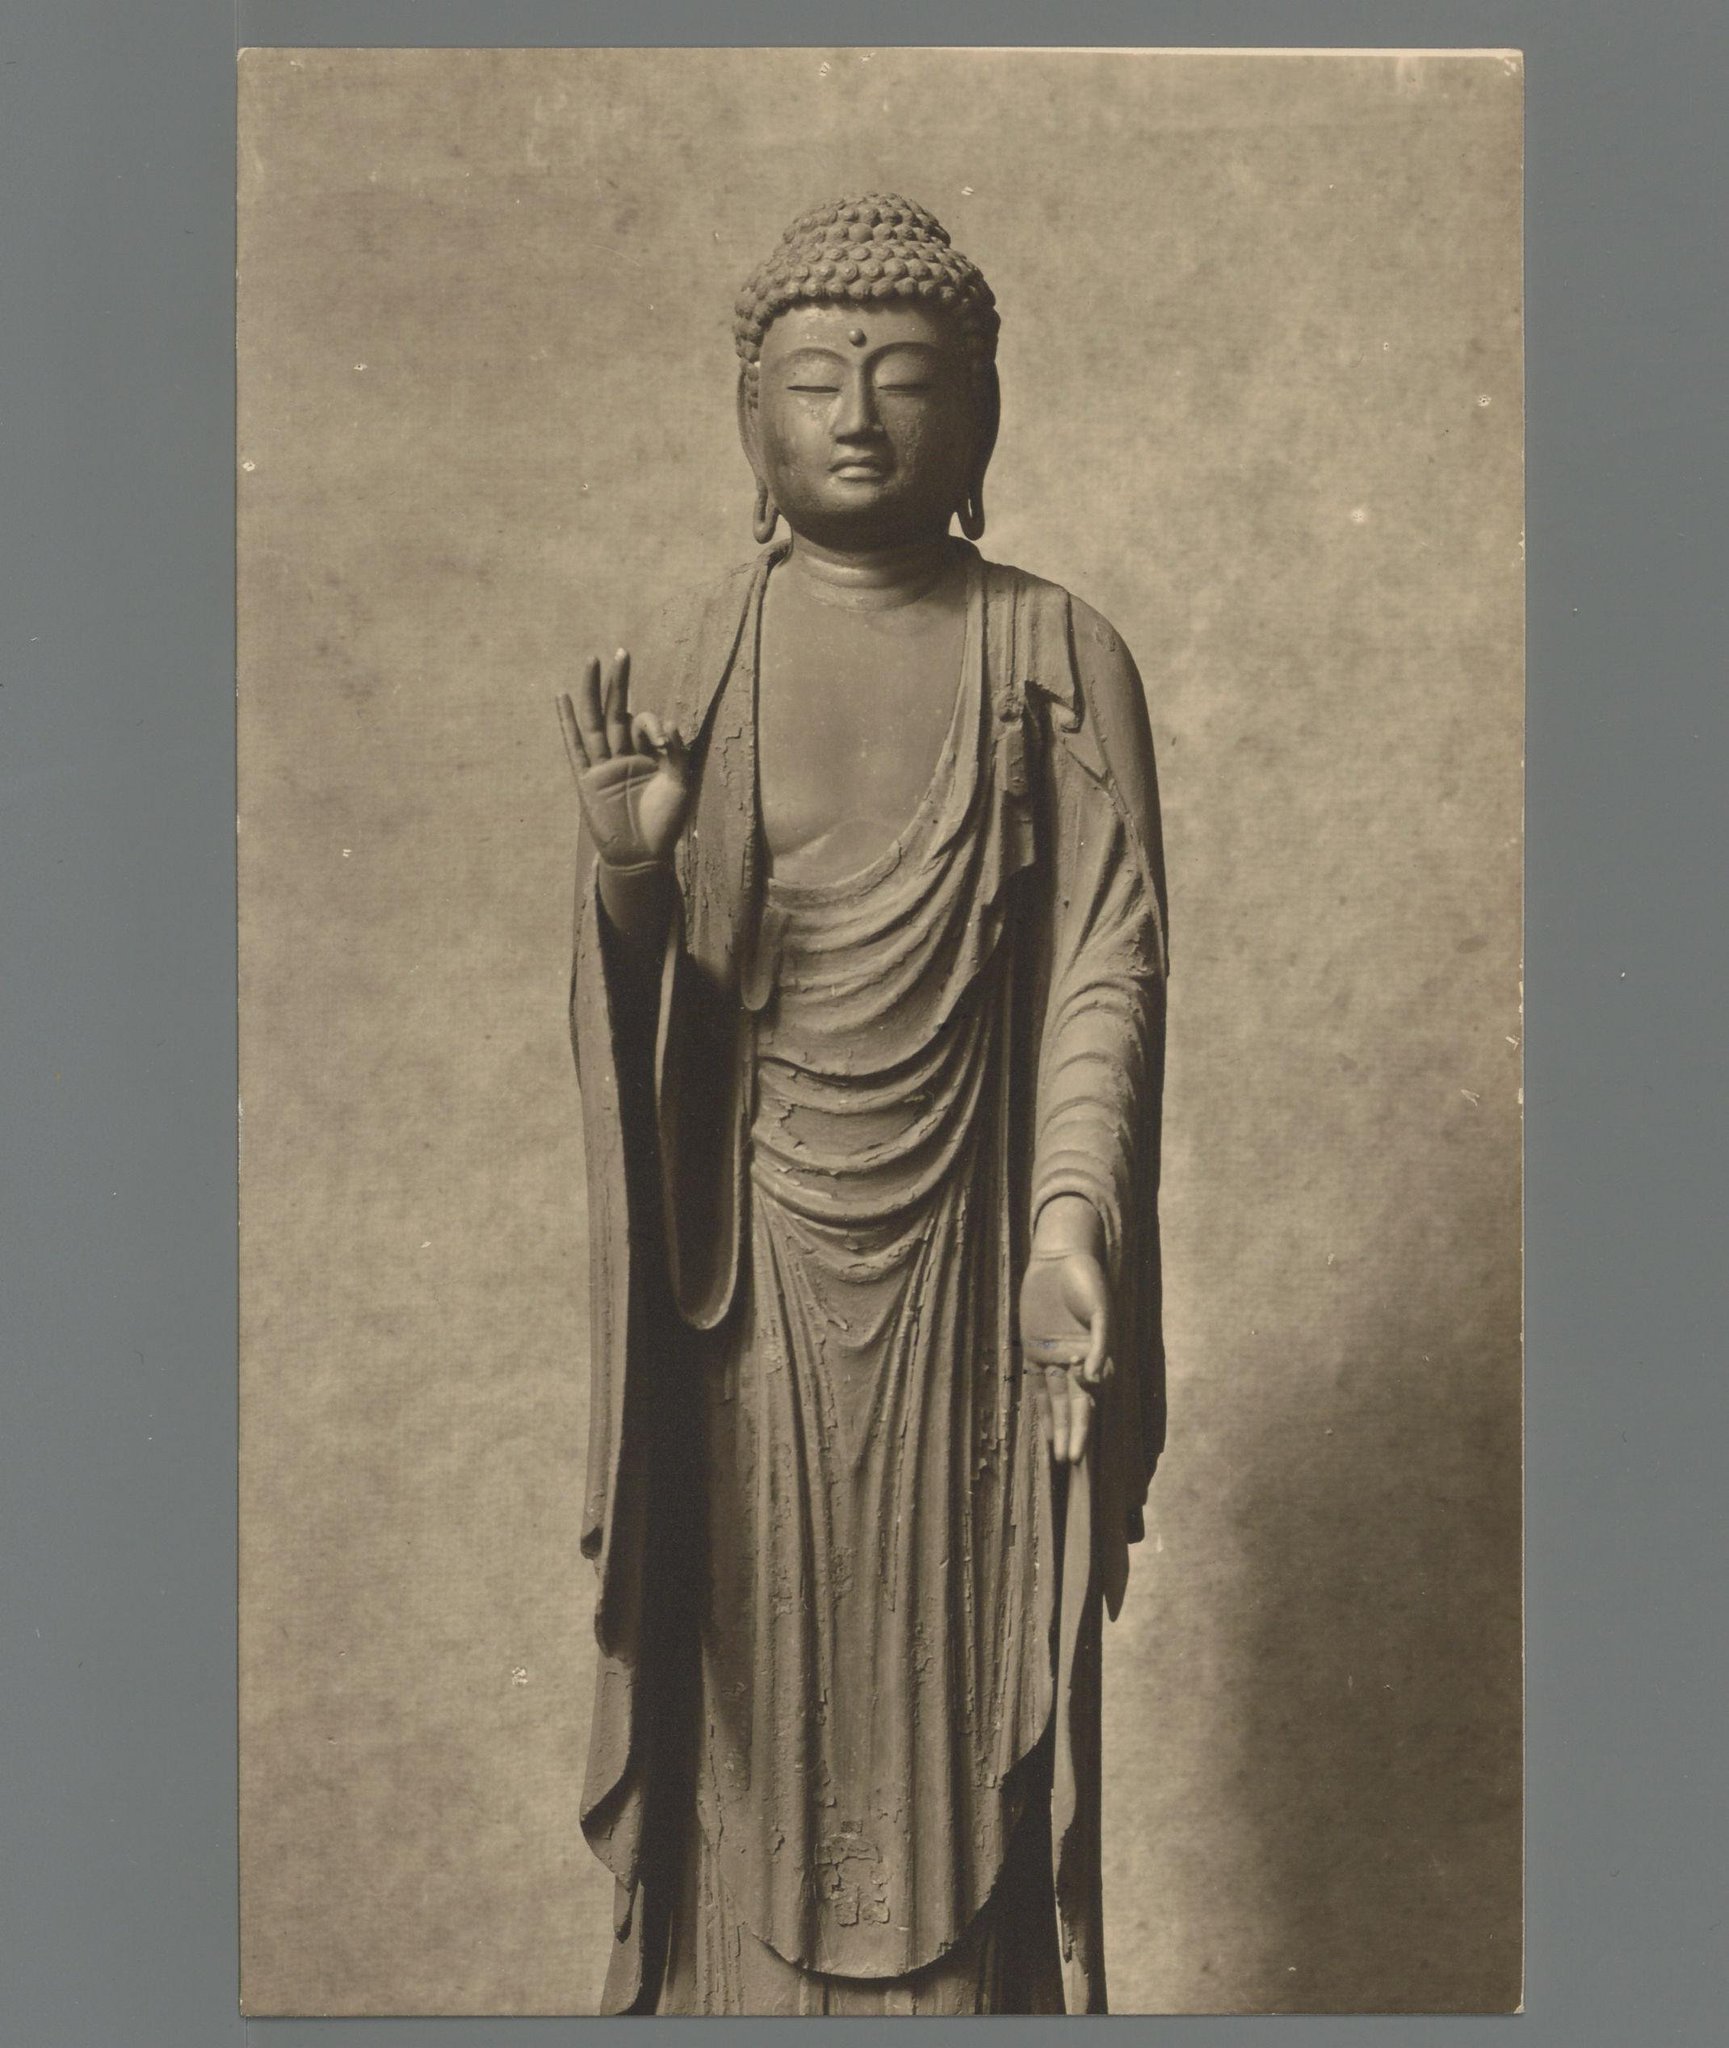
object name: photograph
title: Beeld van een boeddha in het Museum für Ostasiatische Kunst te Keulen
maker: Anonymous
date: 1905-1930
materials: photographic support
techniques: photography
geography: cologne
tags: statues, paintings, etc. ~ objects of worship (traditional chinese religions), permanent exhibition, museum